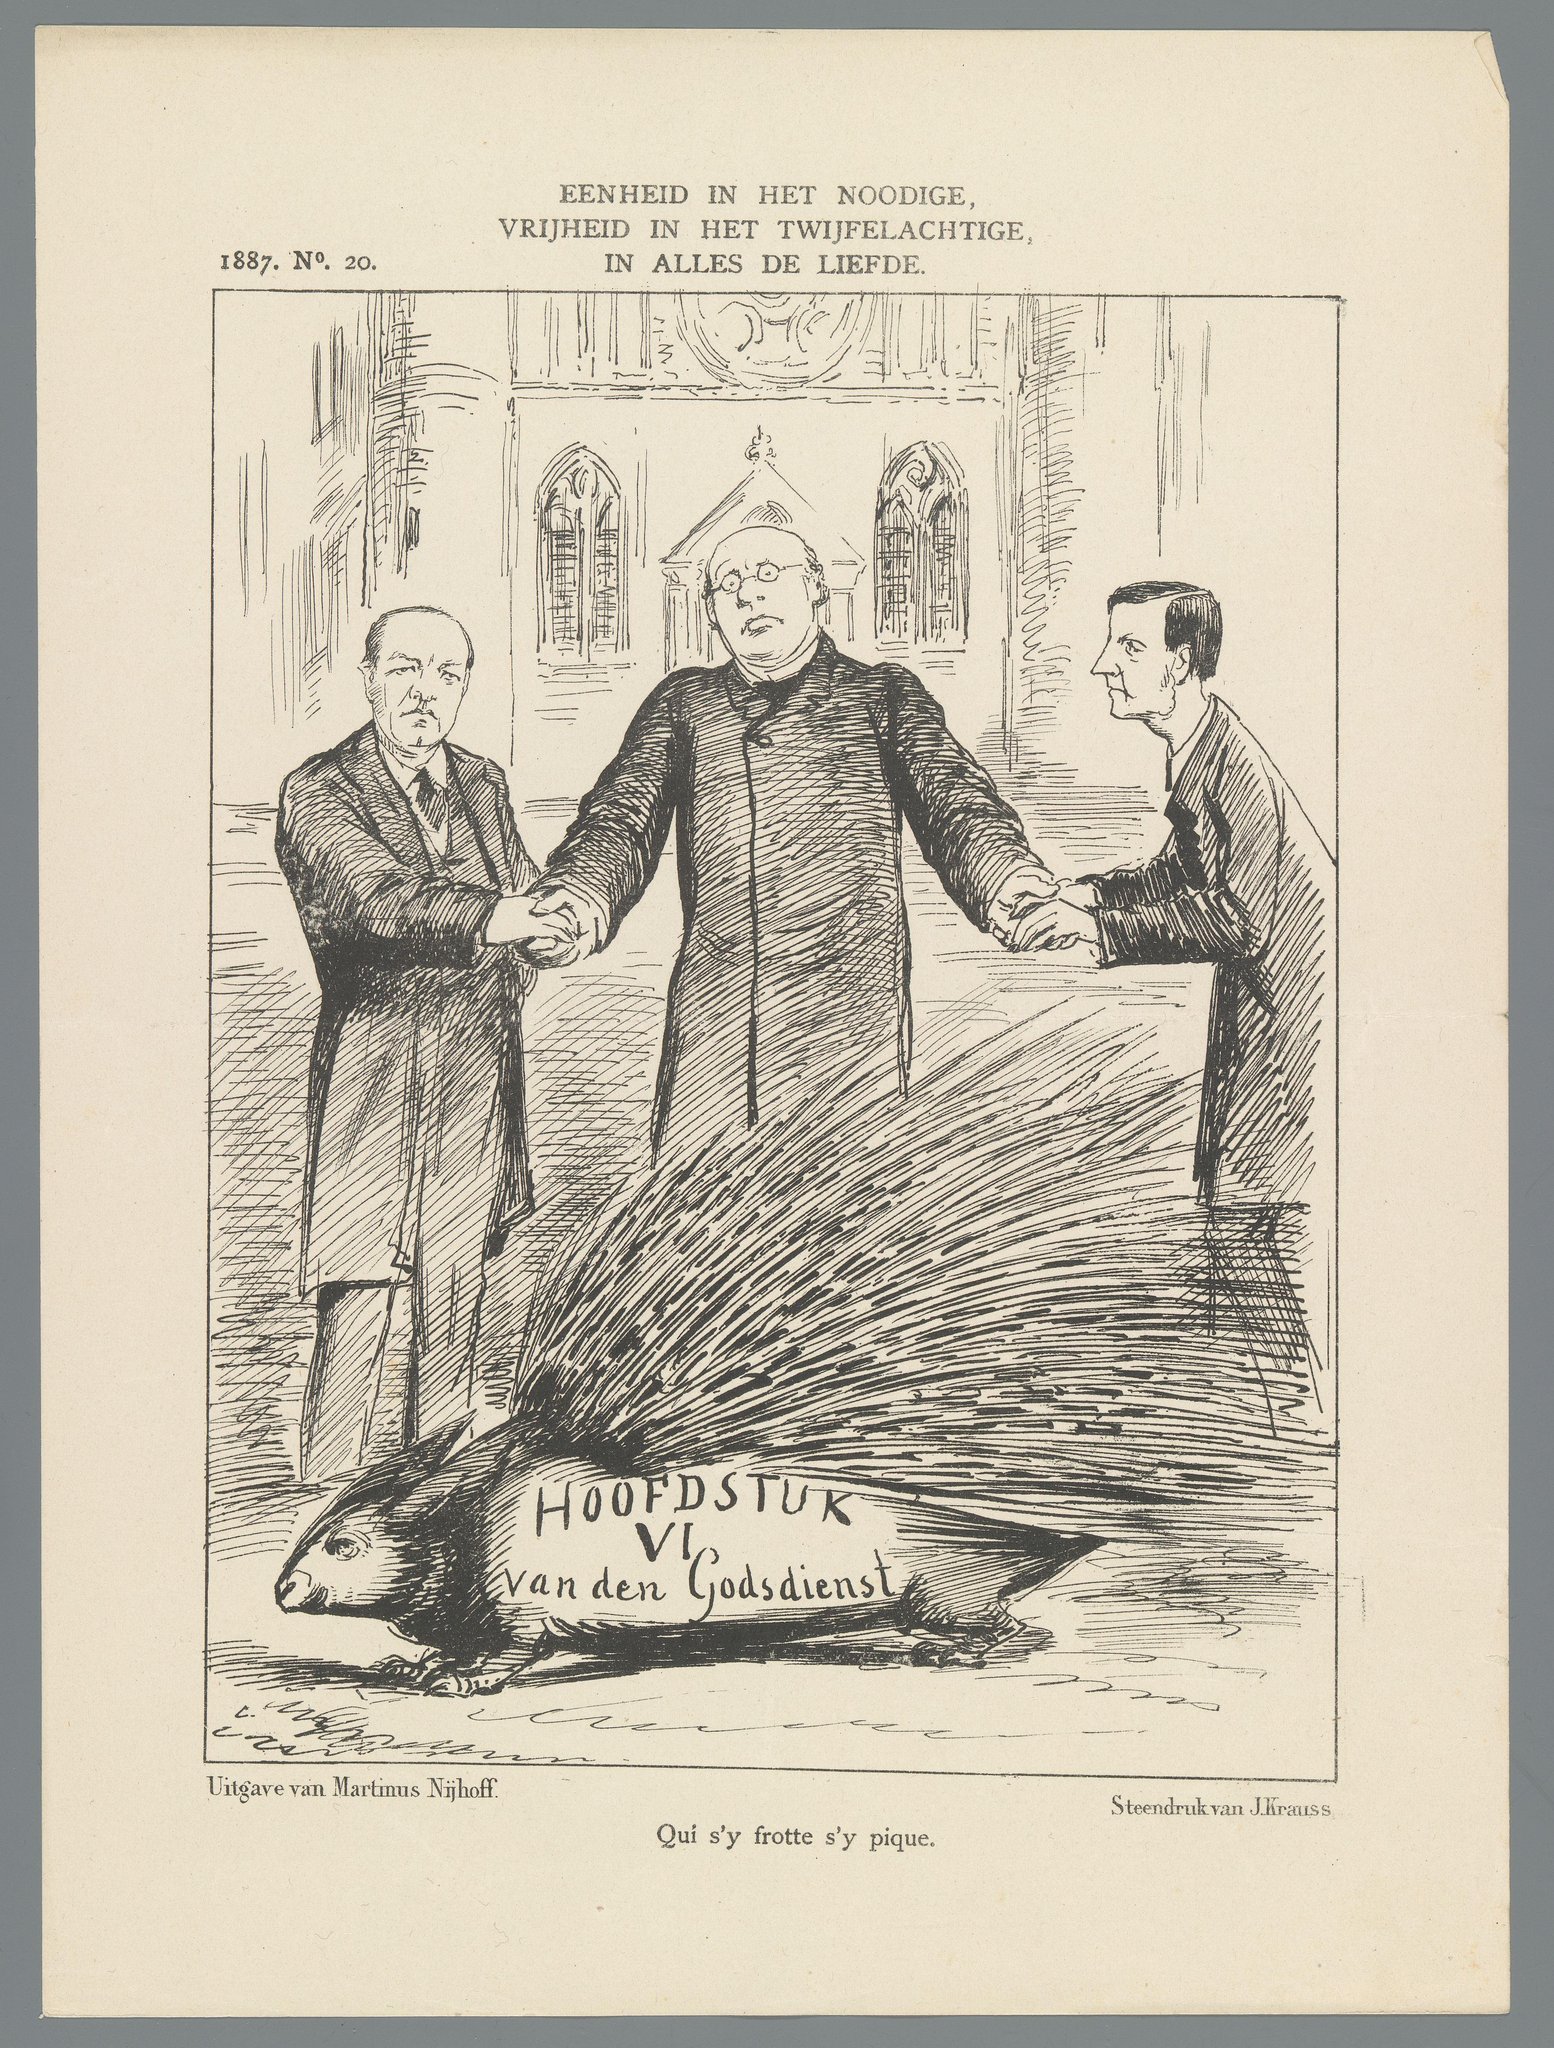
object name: print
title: Spotprent over de christelijke partijen, 1887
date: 1887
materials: paper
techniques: lithograph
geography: the hague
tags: priest, herman johannes aloysius maria schaepman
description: Spotprent over Schaepman en de christelijke partijen. Op de voorgrond een stekelvarken. Plaat verschenen bij het weekblad De Nederlandsche Spectator, nr. 20, 1887.